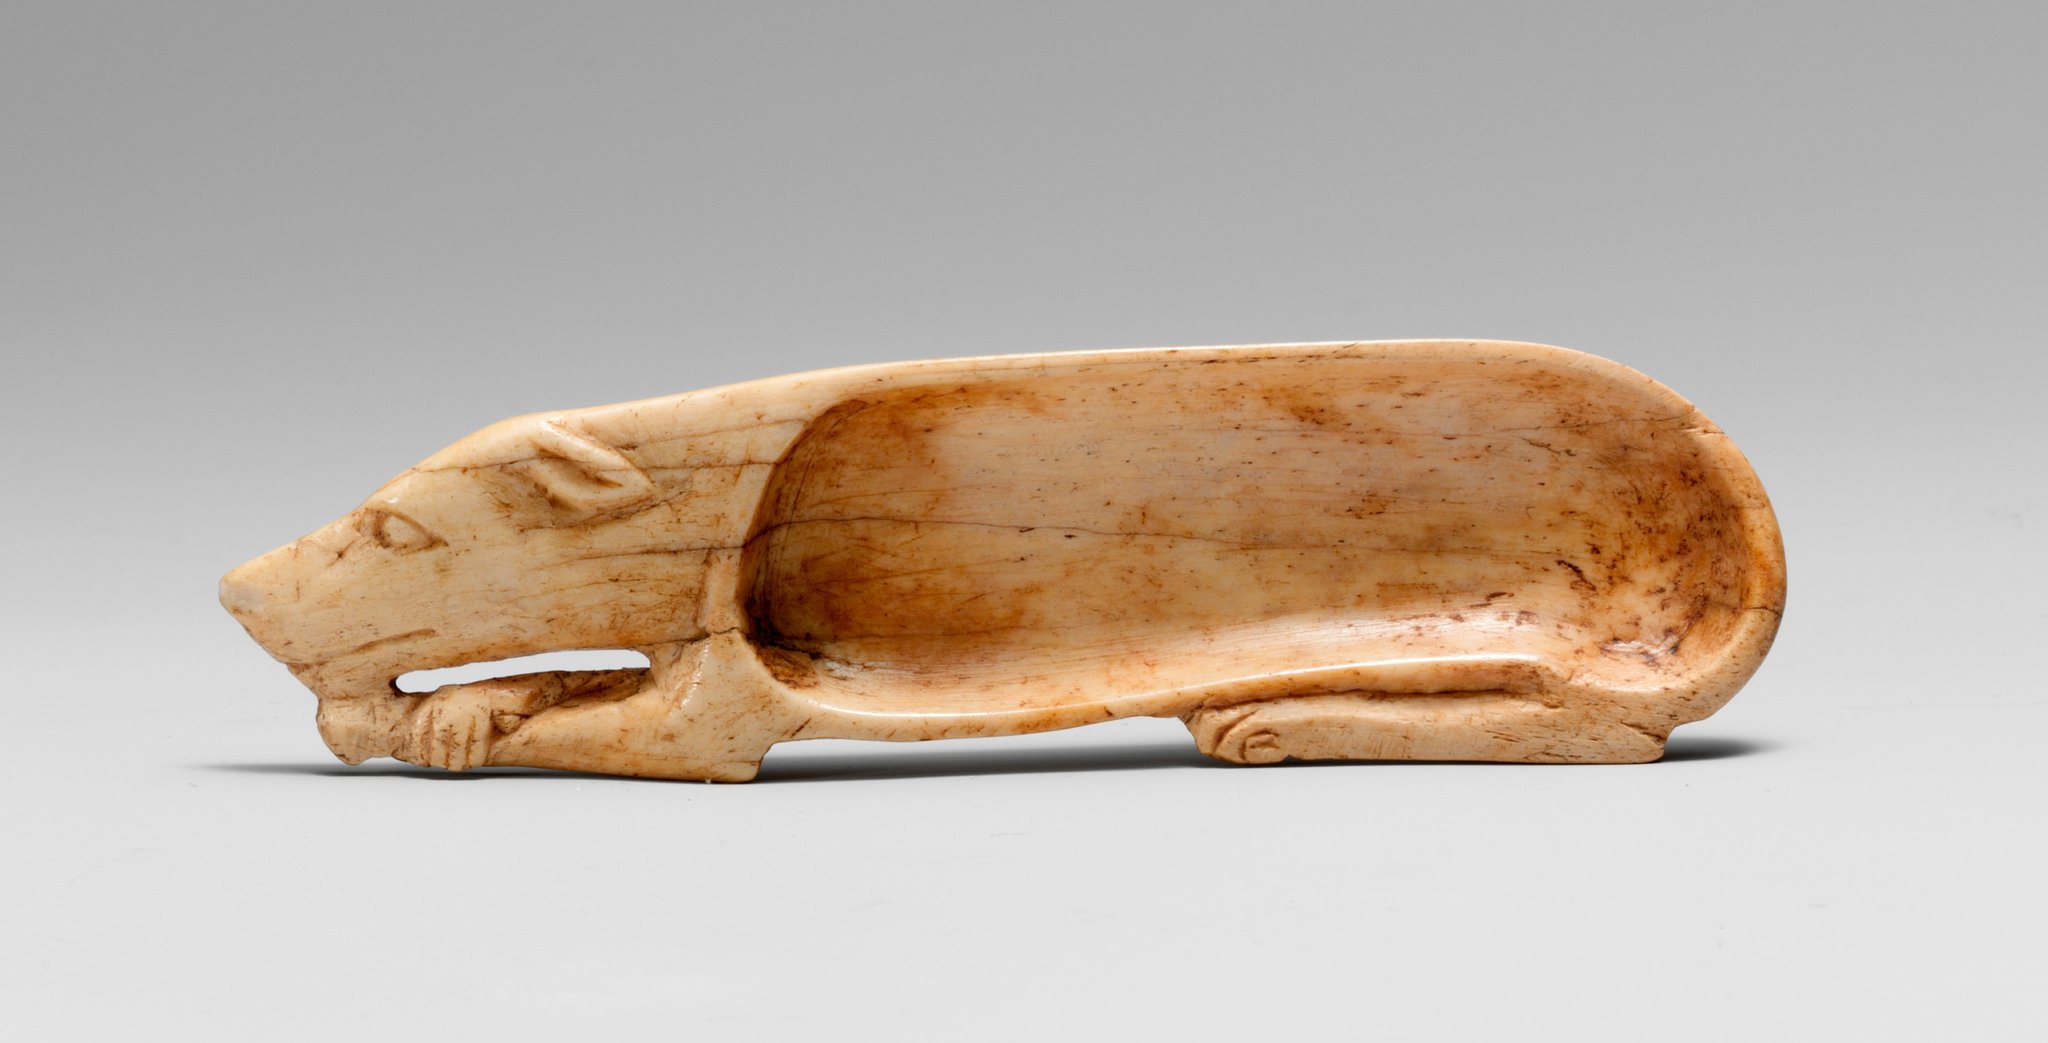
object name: cosmetic spoon, dog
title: Cosmetic dish in the shape of a dog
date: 1550-1295 BCE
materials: bone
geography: egypt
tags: dogs